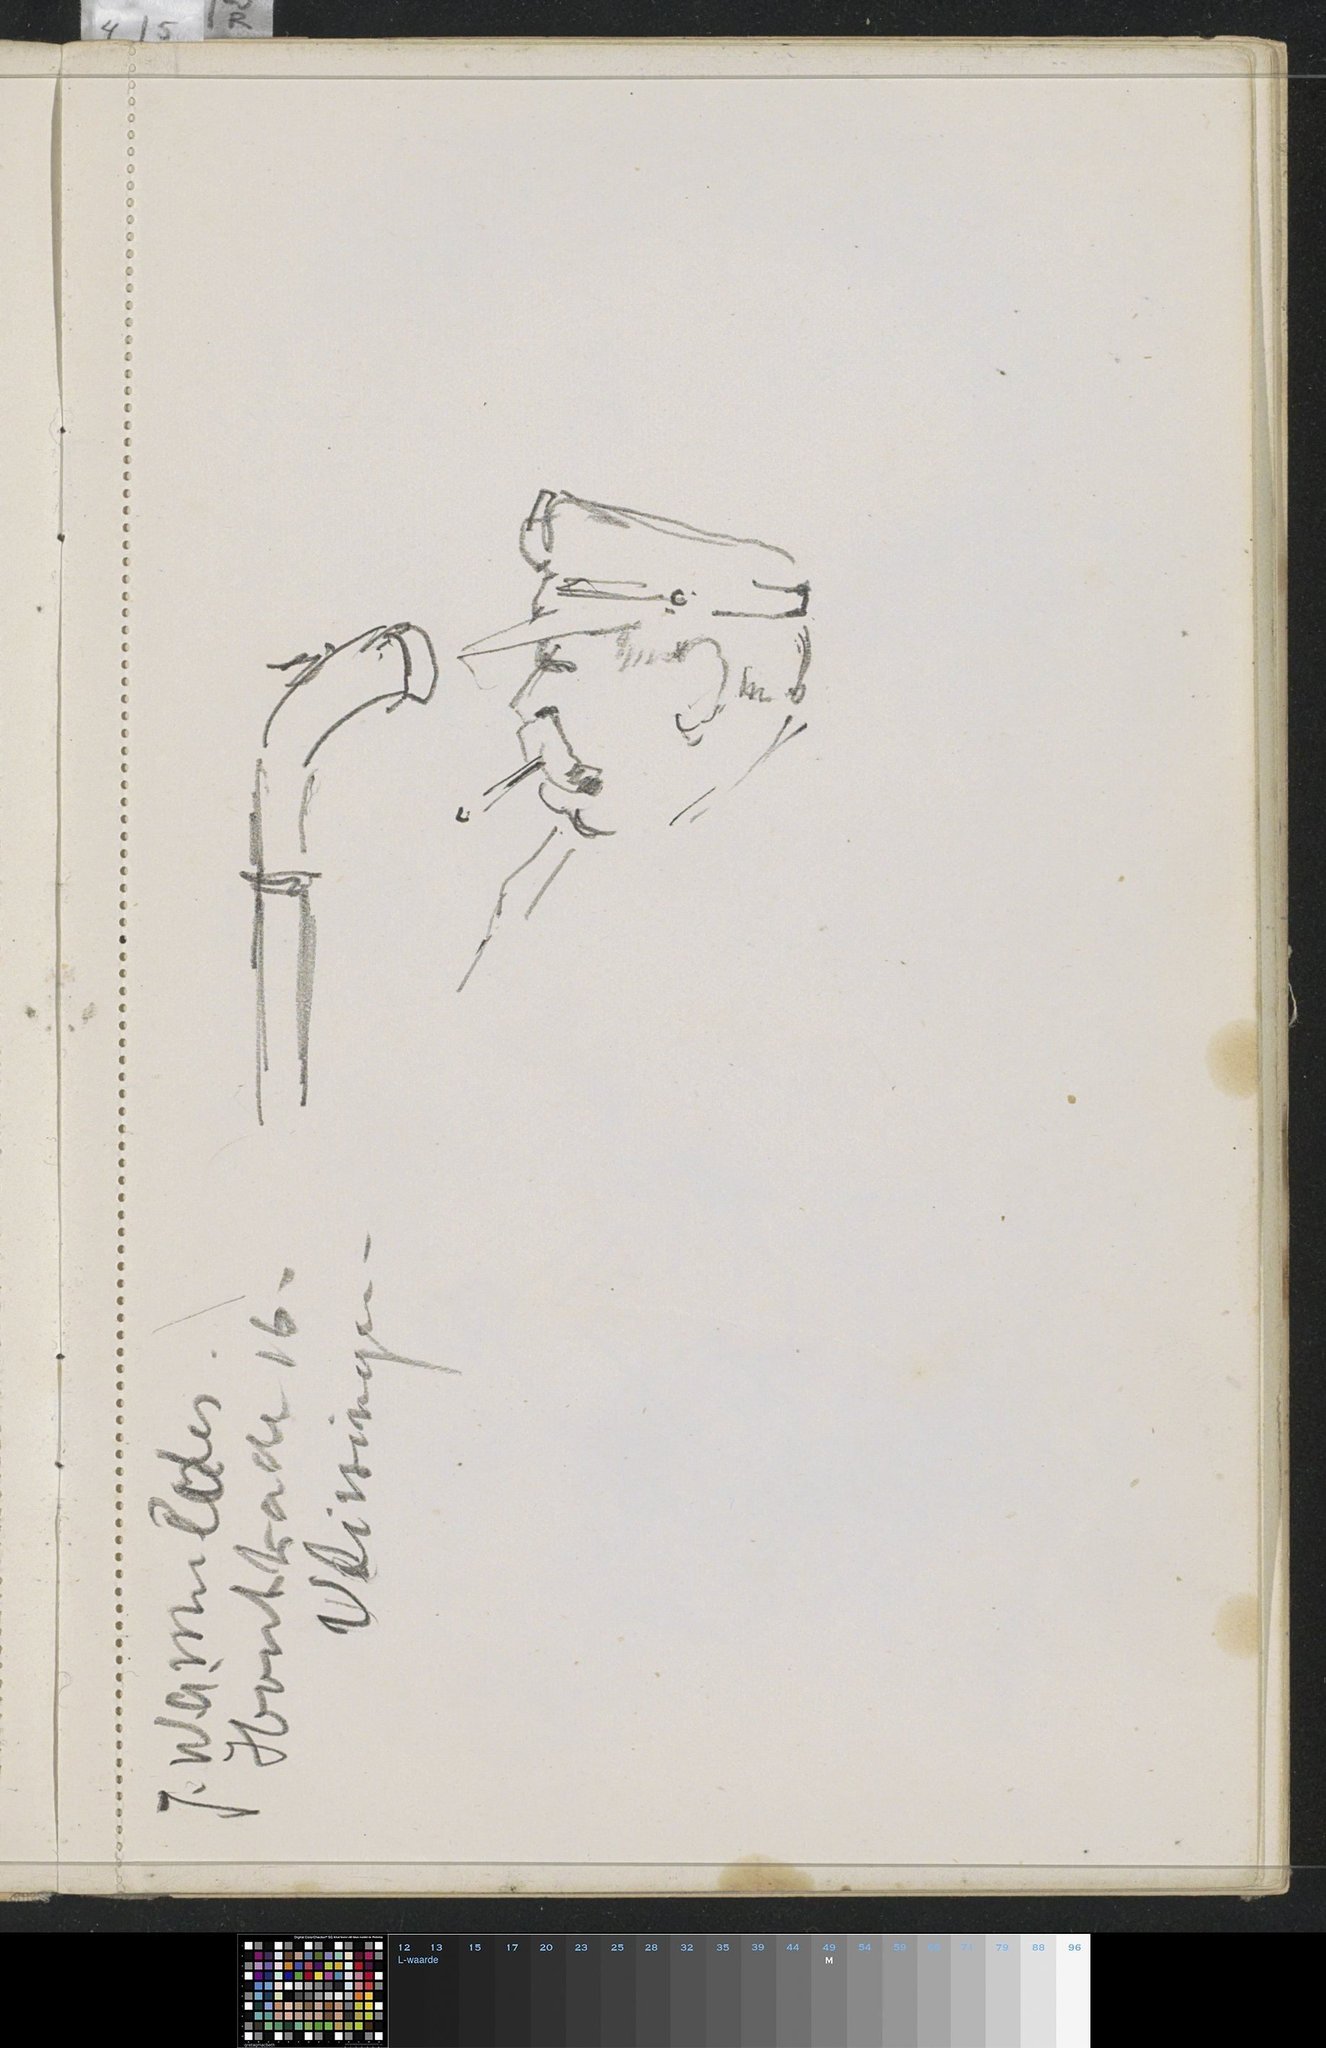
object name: sketchbook leaf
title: Man met een pet en sigaret naast een pijp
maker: cornelis vreedenburgh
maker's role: draughtsman, print maker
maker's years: 1880-1946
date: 1890-1946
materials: paper, pencil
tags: cigarette, adult man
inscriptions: annotation: ‘J.WaMulder/ Houtkade 16./ Vlissingen’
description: Blad 3 recto uit een schetsboek met 53 bladen.